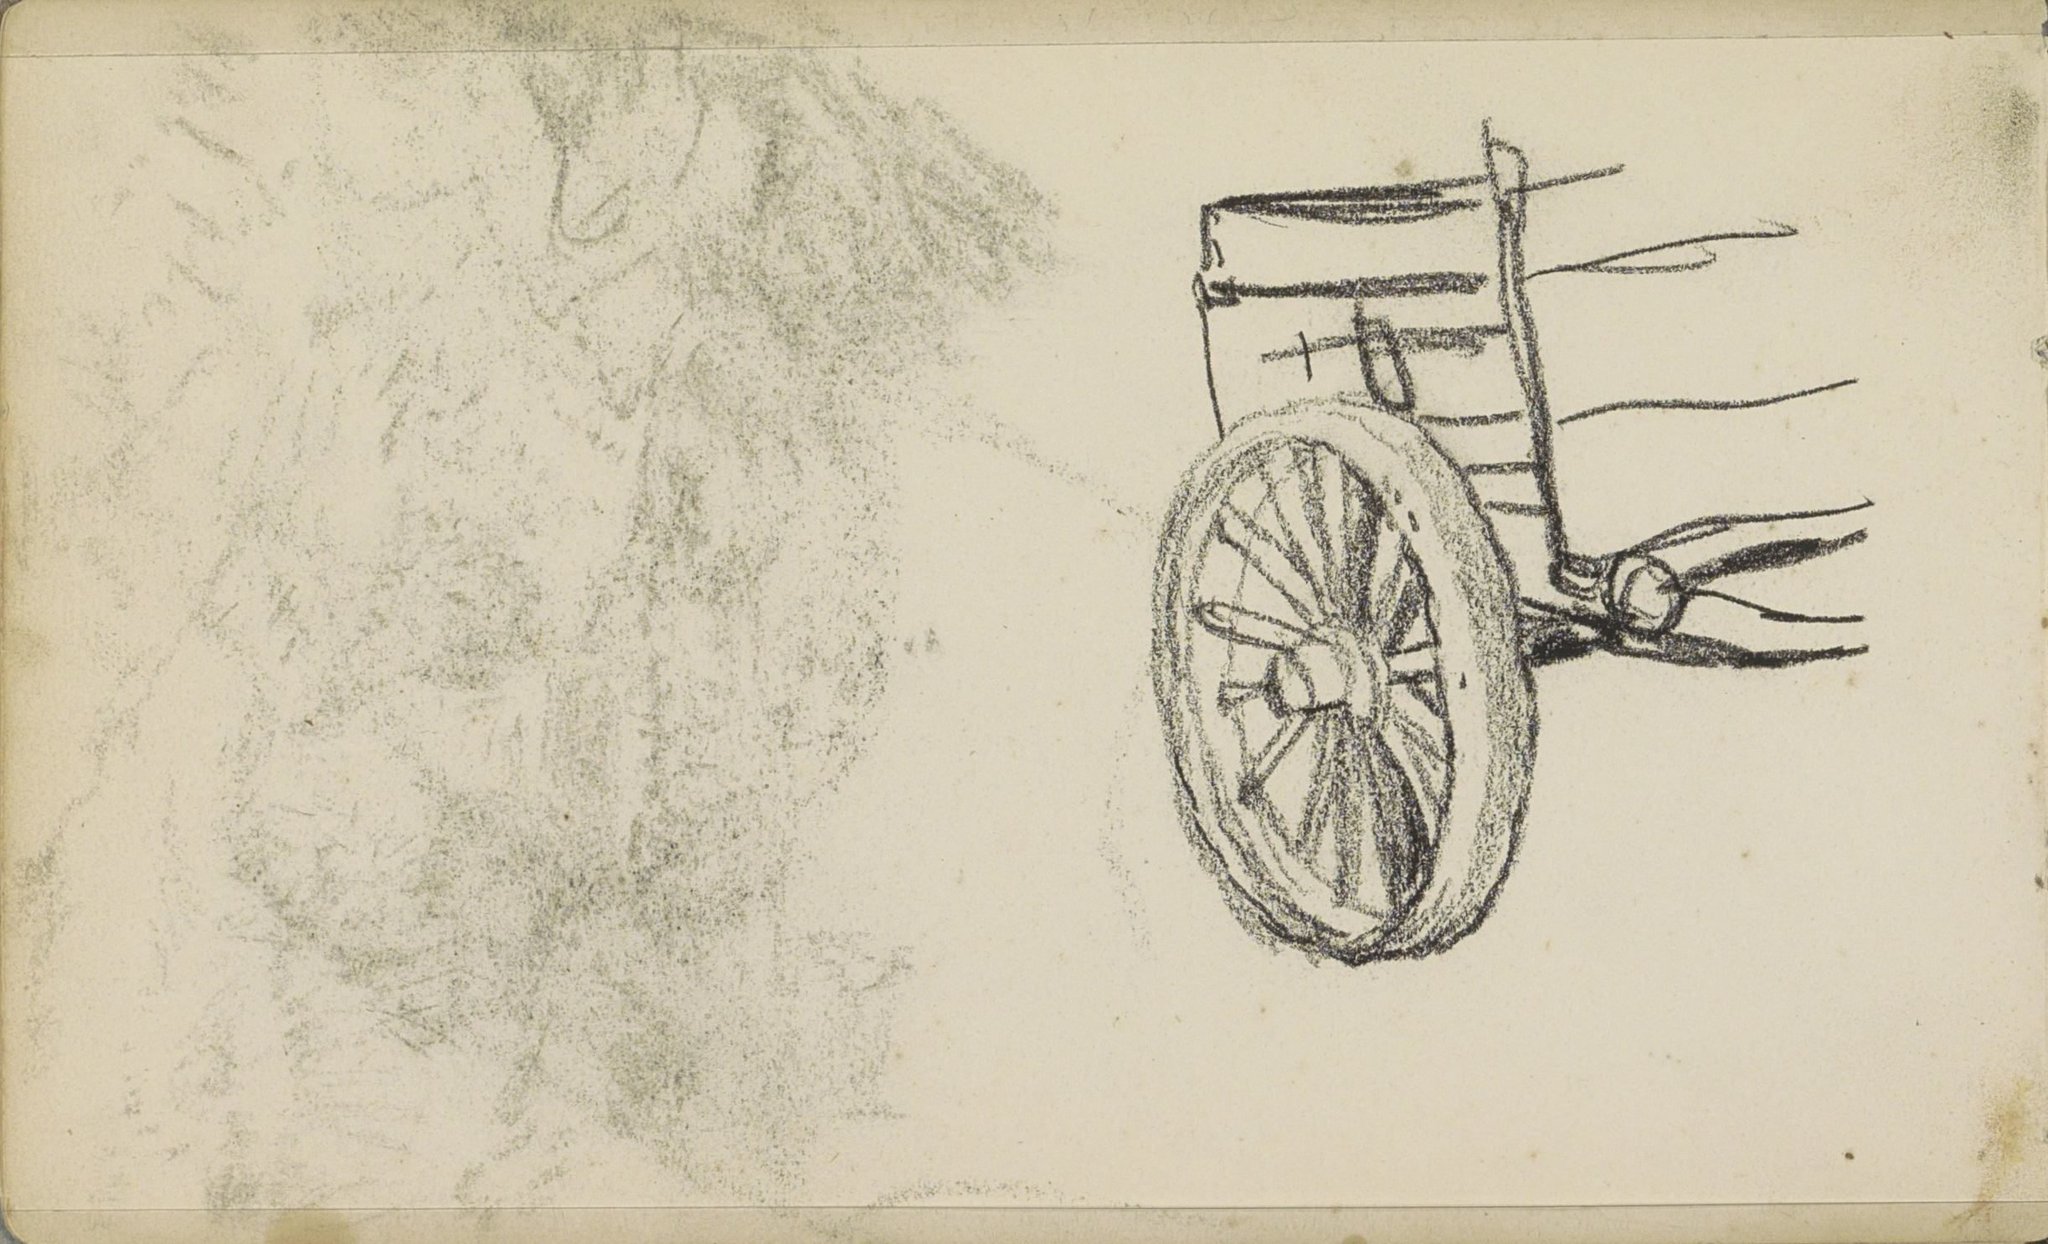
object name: sketchbook leaf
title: Kar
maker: jozef israëls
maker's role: draughtsman, painter, print maker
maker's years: 1824-1911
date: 1834-1911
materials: chalk, paper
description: Blad 3 verso uit een schetsboek met 42 bladen.